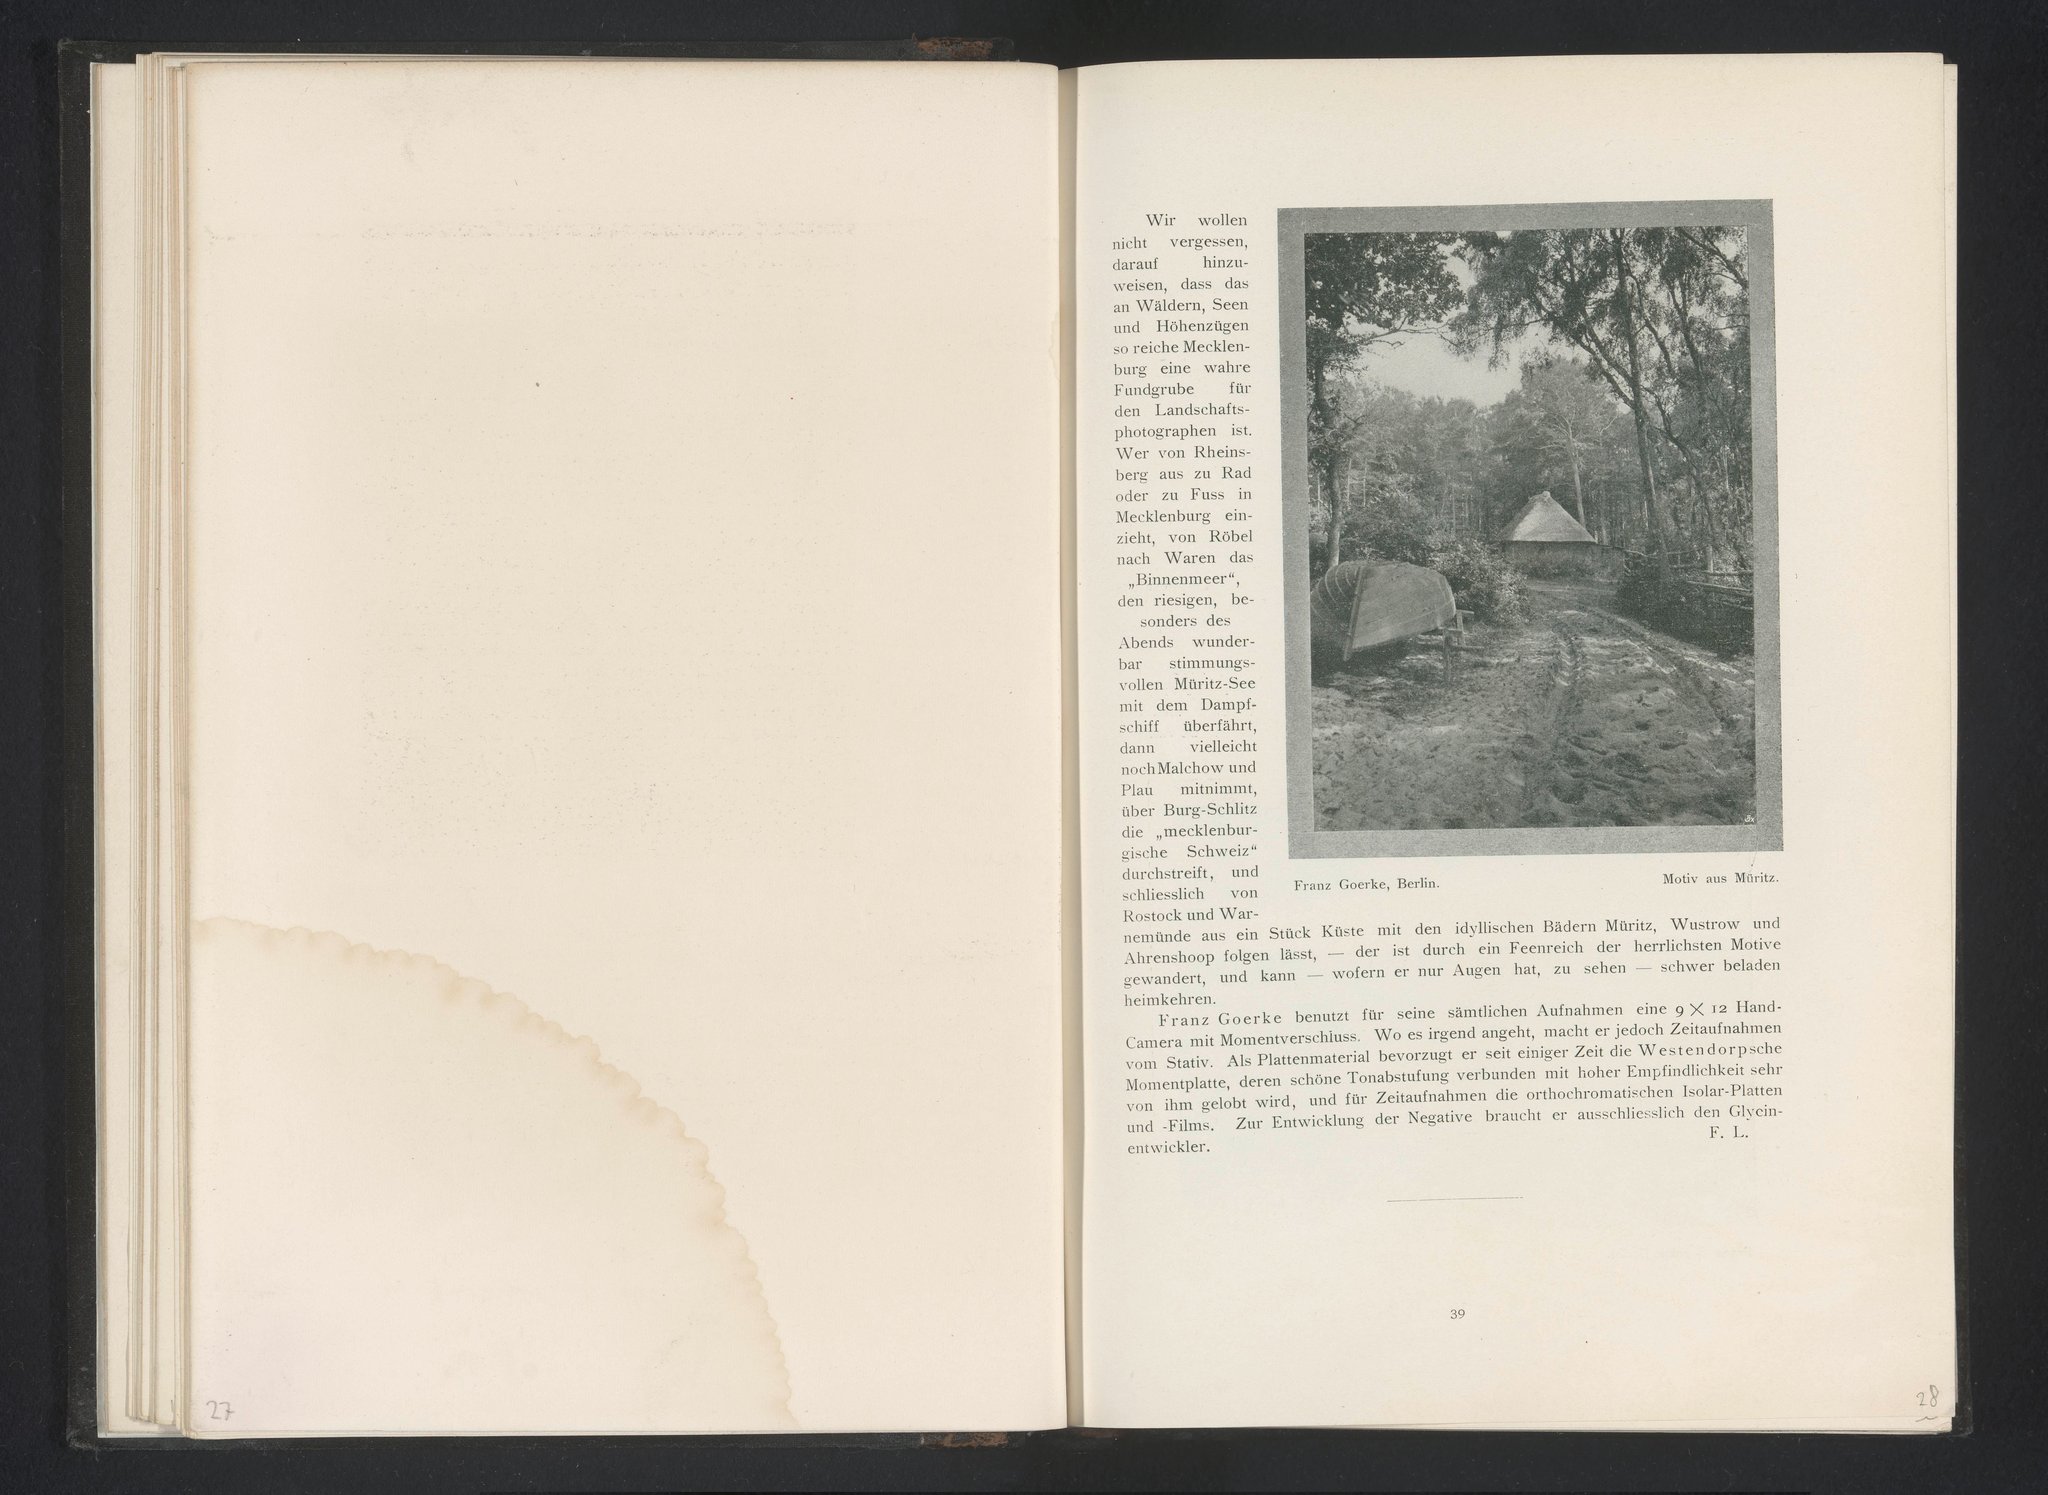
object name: page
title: Motiv aus Müritz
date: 1898-1903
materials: paper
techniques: autotype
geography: mecklenburg-western pomerania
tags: landscapes, hut, cabin, lodge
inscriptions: inscription: ‘Berlin’, monogram: ‘BX’